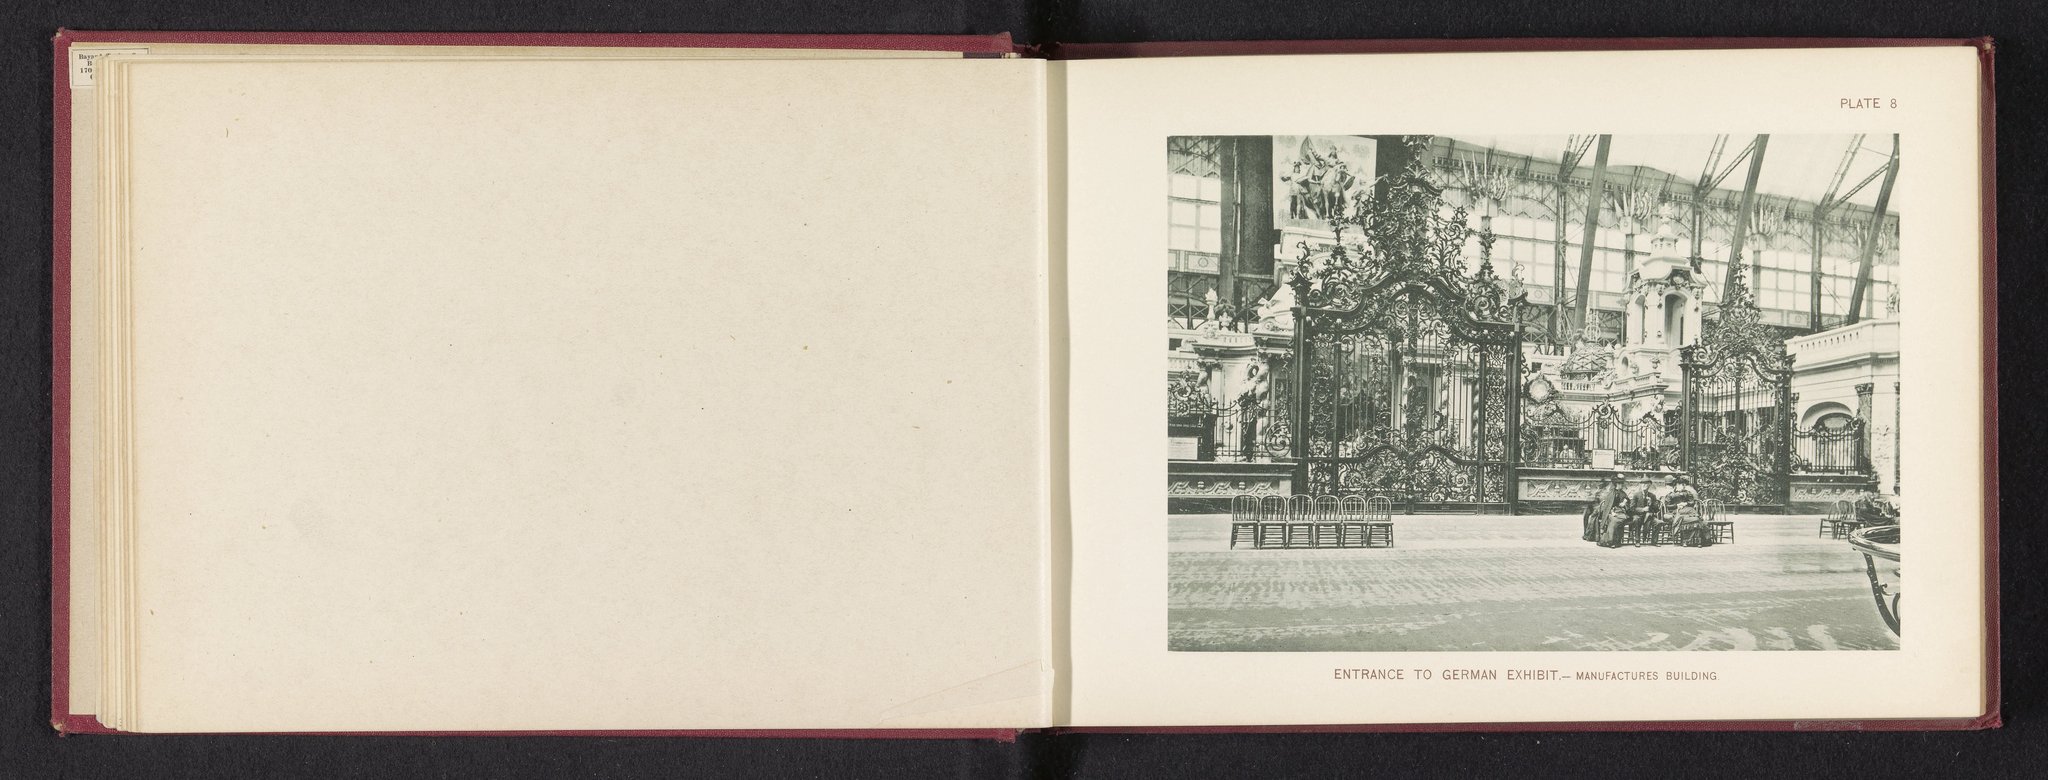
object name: page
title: Toegangshekken naar de Duitse tentoonstelling tijdens de World's Columbian Exposition in Chicago in 1893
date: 1893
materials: paper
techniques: photograph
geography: chicago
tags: world fair, world exhibition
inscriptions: number: ‘Plate 8’